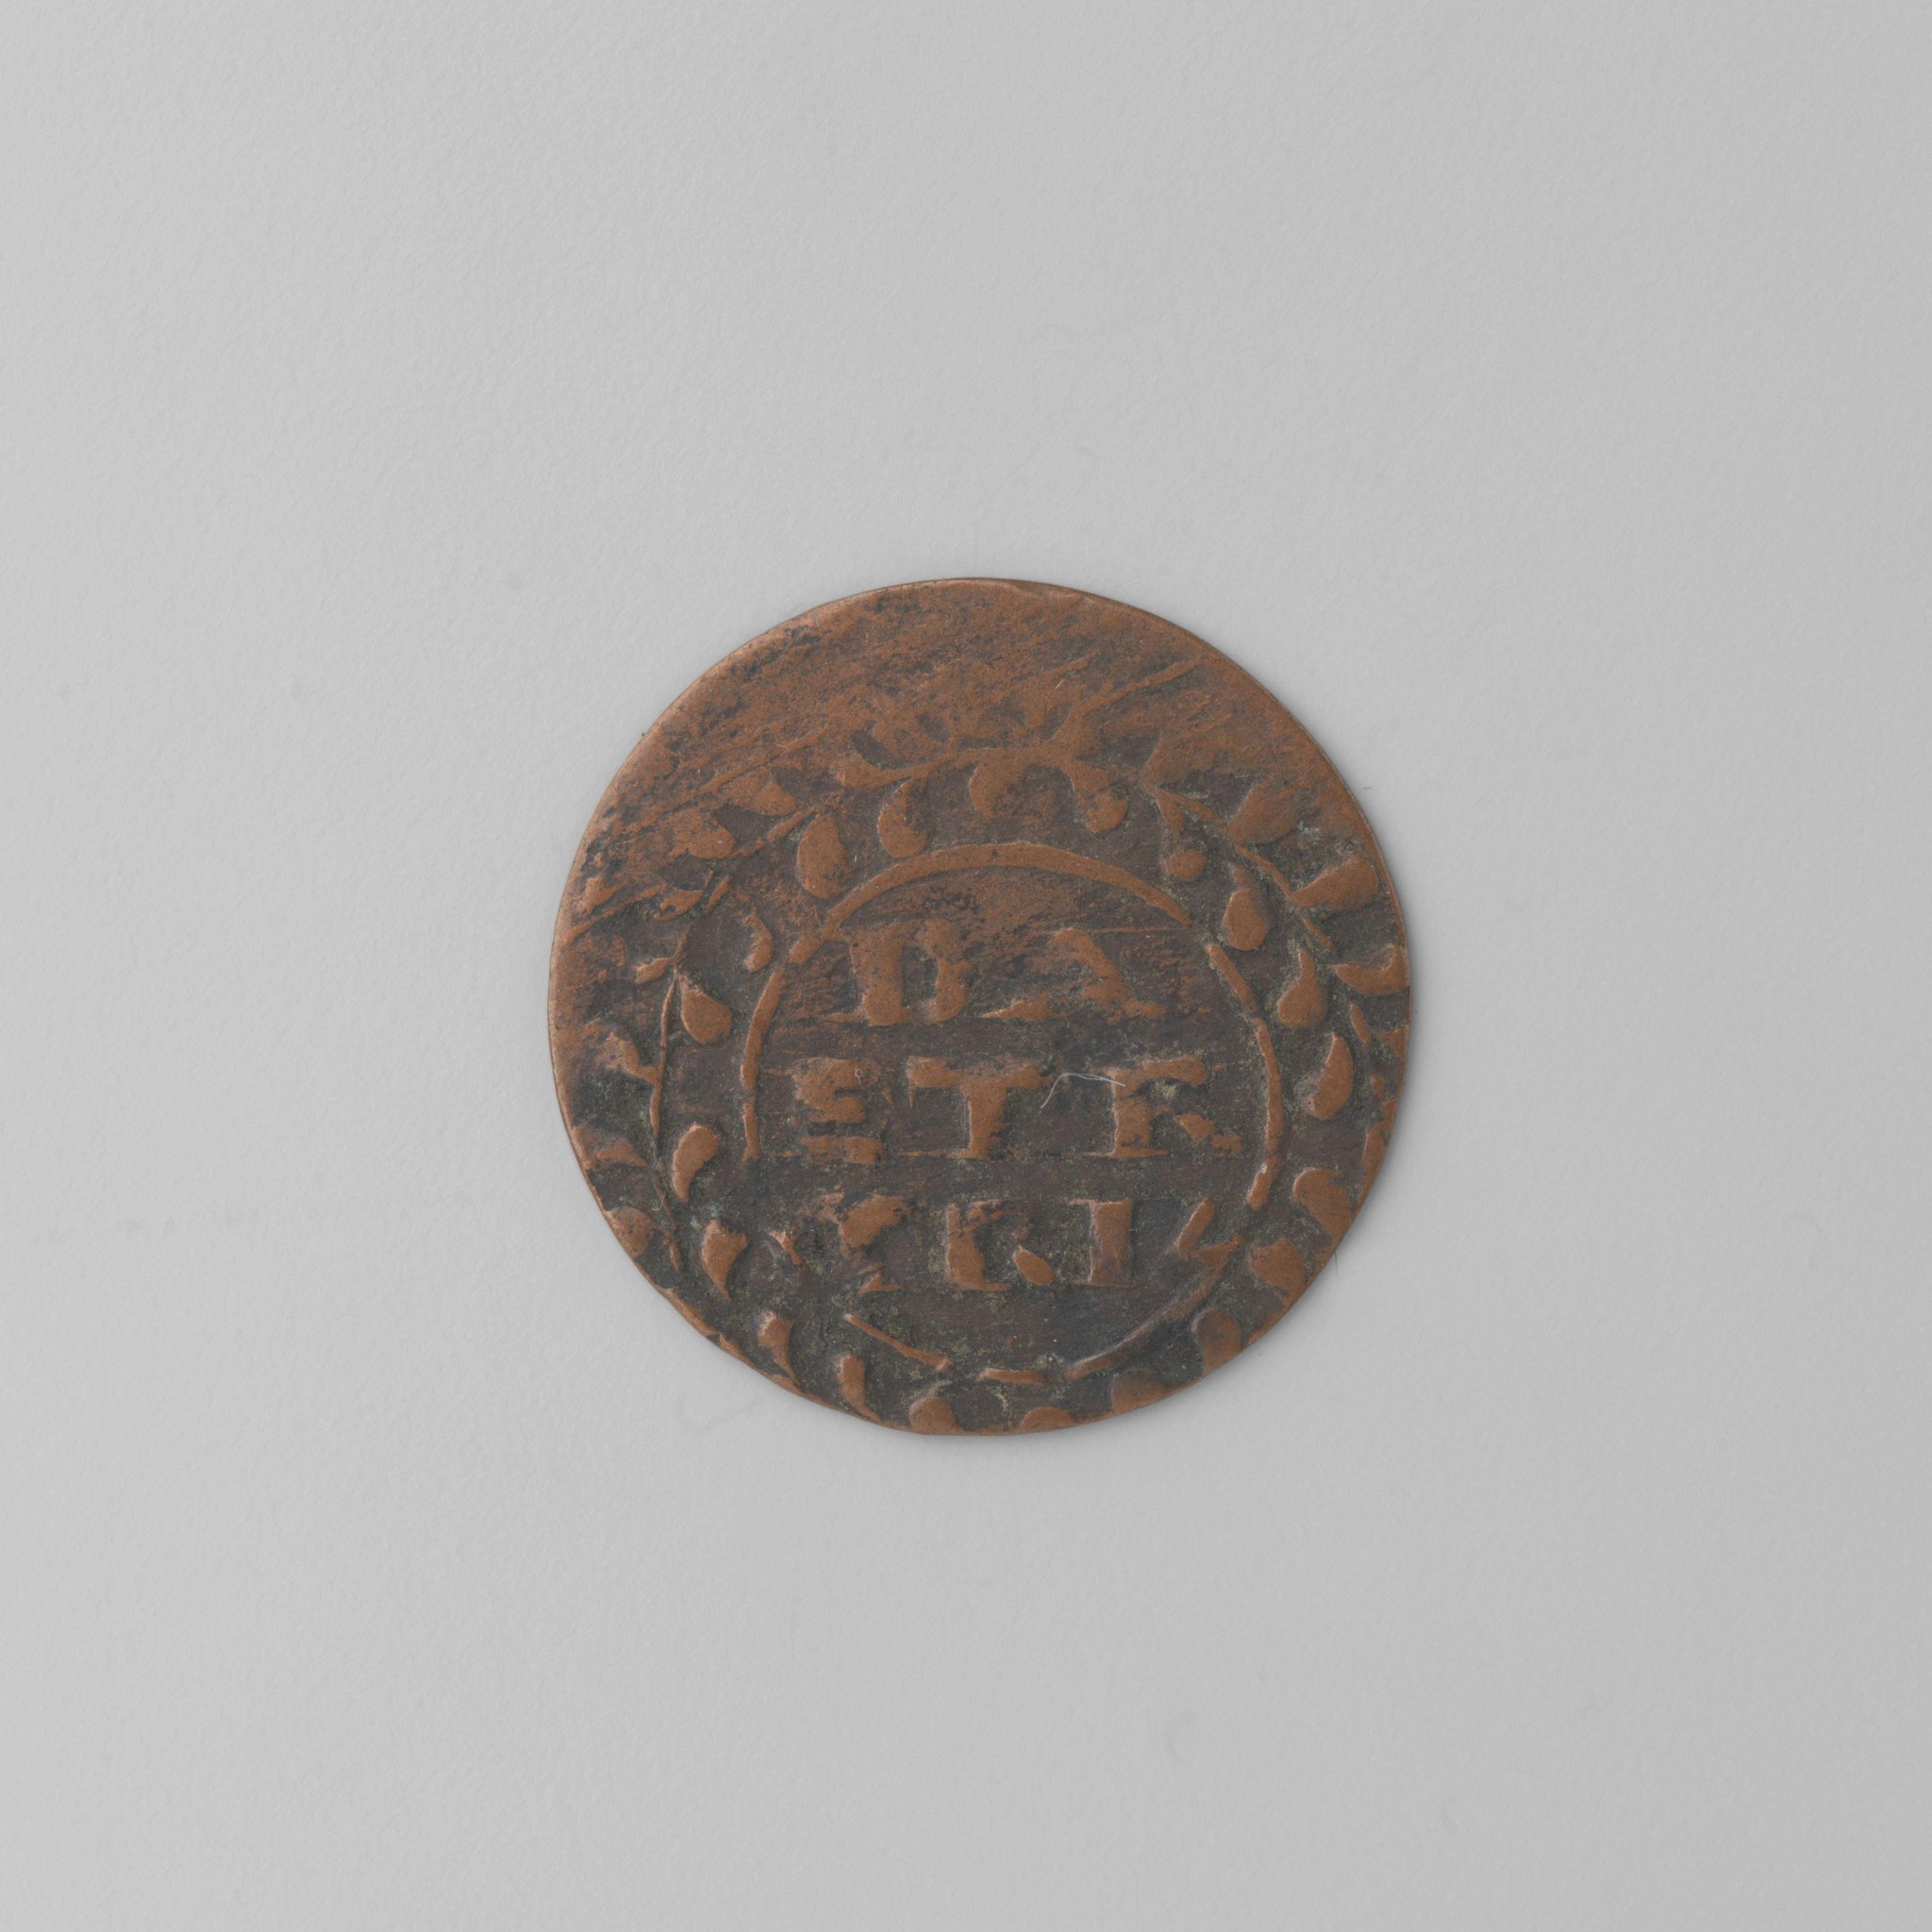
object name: coin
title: Reckheim, Ferdinand van Aspremont-Lynden (1636-1665), duit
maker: heer van reckheim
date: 1636-1665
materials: copper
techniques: striking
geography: rekem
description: Koperen munt. Voorzijde: versierd gekroond wapenschild van Deventer. Keerzijde: binnen een krans drie-regelig opschrift.